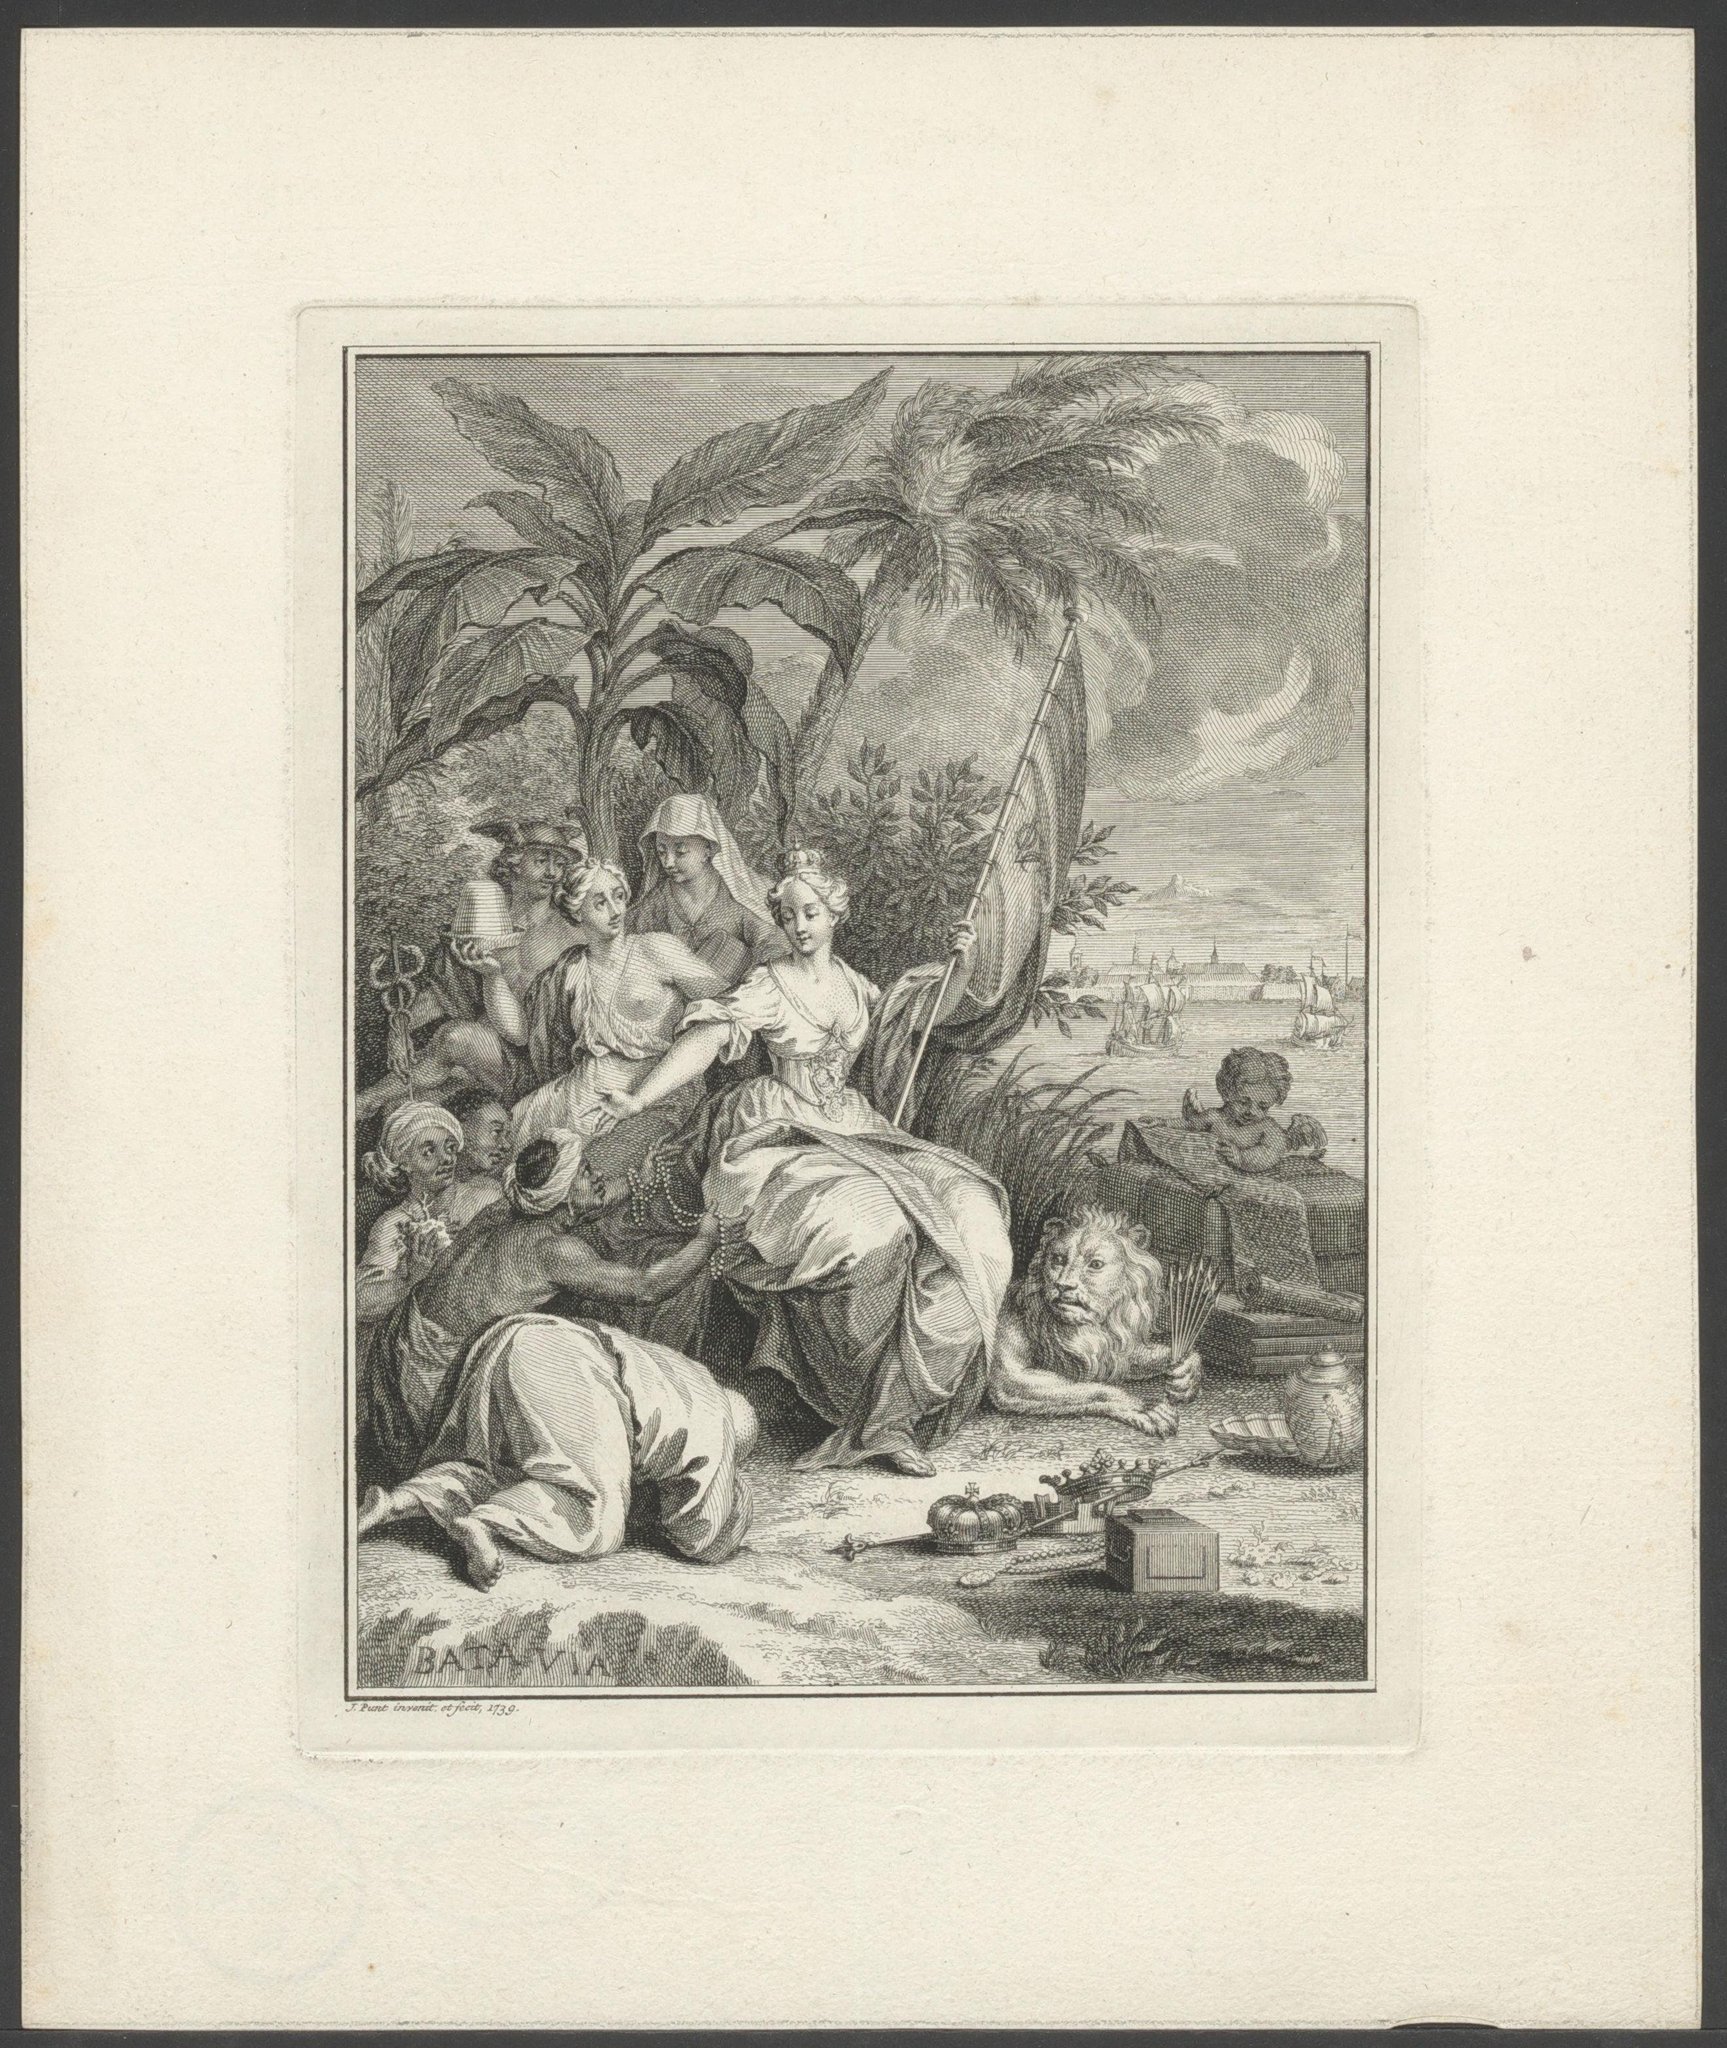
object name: print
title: Allegorie op de VOC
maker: jan punt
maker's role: draughtsman, print maker, publisher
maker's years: 1711-1779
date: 1739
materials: paper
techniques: engraving, etching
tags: asiatic races and peoples, personifications of countries, nations, states, districts, etc., (story of) mercury (hermes), africans, freedom, liberty; 'libertà' (ripa), batavia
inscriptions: stamp, collector's mark: Lugt 1641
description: Allegorie op de Verenigde Oost-Indische Compagnie. Batavia houdt een vlag vast met het monogram van de VOC. Naast haar ligt de Hollandse leeuw. Afrikaanse en Oosterse mannen buigen voor haar en bieden haar cadeaus met koninklijke voorrechten aan. Links staat Mercurius, god van de handel, Vrijheid en een derde allegorische figuur. Aan de rechterzijde bekijkt een engeltje een kostbare stof. Op de achtergrond een gezicht op de stad Batavia, het middelpunt van de bezittingen van de Nederlanders. De prent illustreert de trots van de Nederlanders op hun koloniale gebieden. Onderwerpsrubrieken binnen de Atlas Zeden en Gewoonten: Zeden en Gewoonten in engeren zin. Volksleven. Zinnebeeldige voorstellingen uit het volkleven op serieprenten. Maanden en diversen (allegorieën).